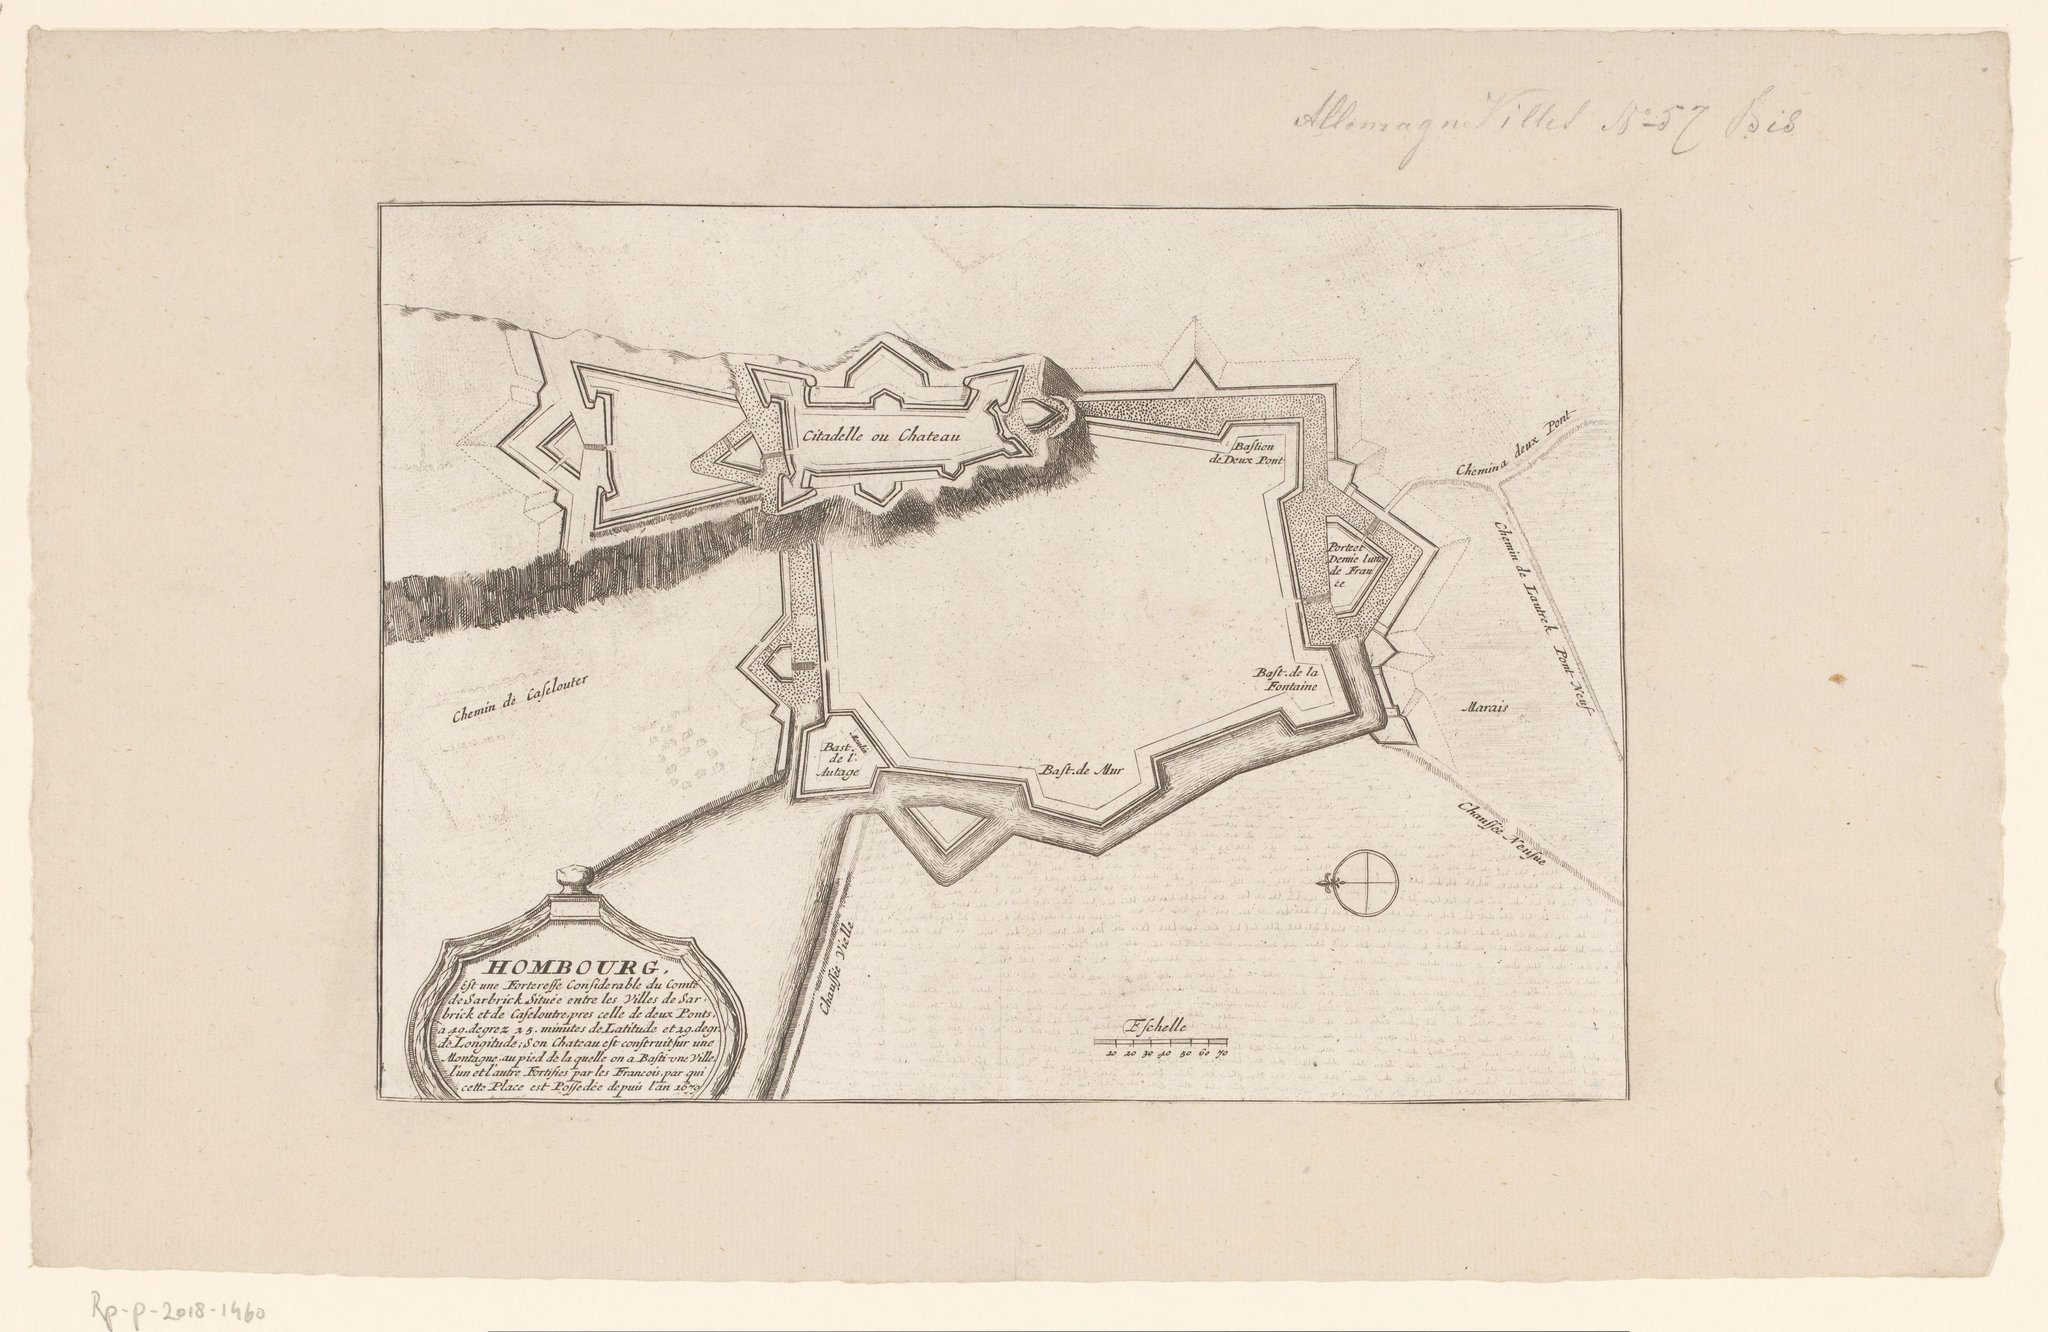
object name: area plan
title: Hombourg, est une fortresse considerable du comté de Sarbrick (...)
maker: Anonymous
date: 1690-1698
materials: paper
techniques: engraving, etching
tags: fortified city, maps of cities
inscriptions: collector's mark: Lugt 2228